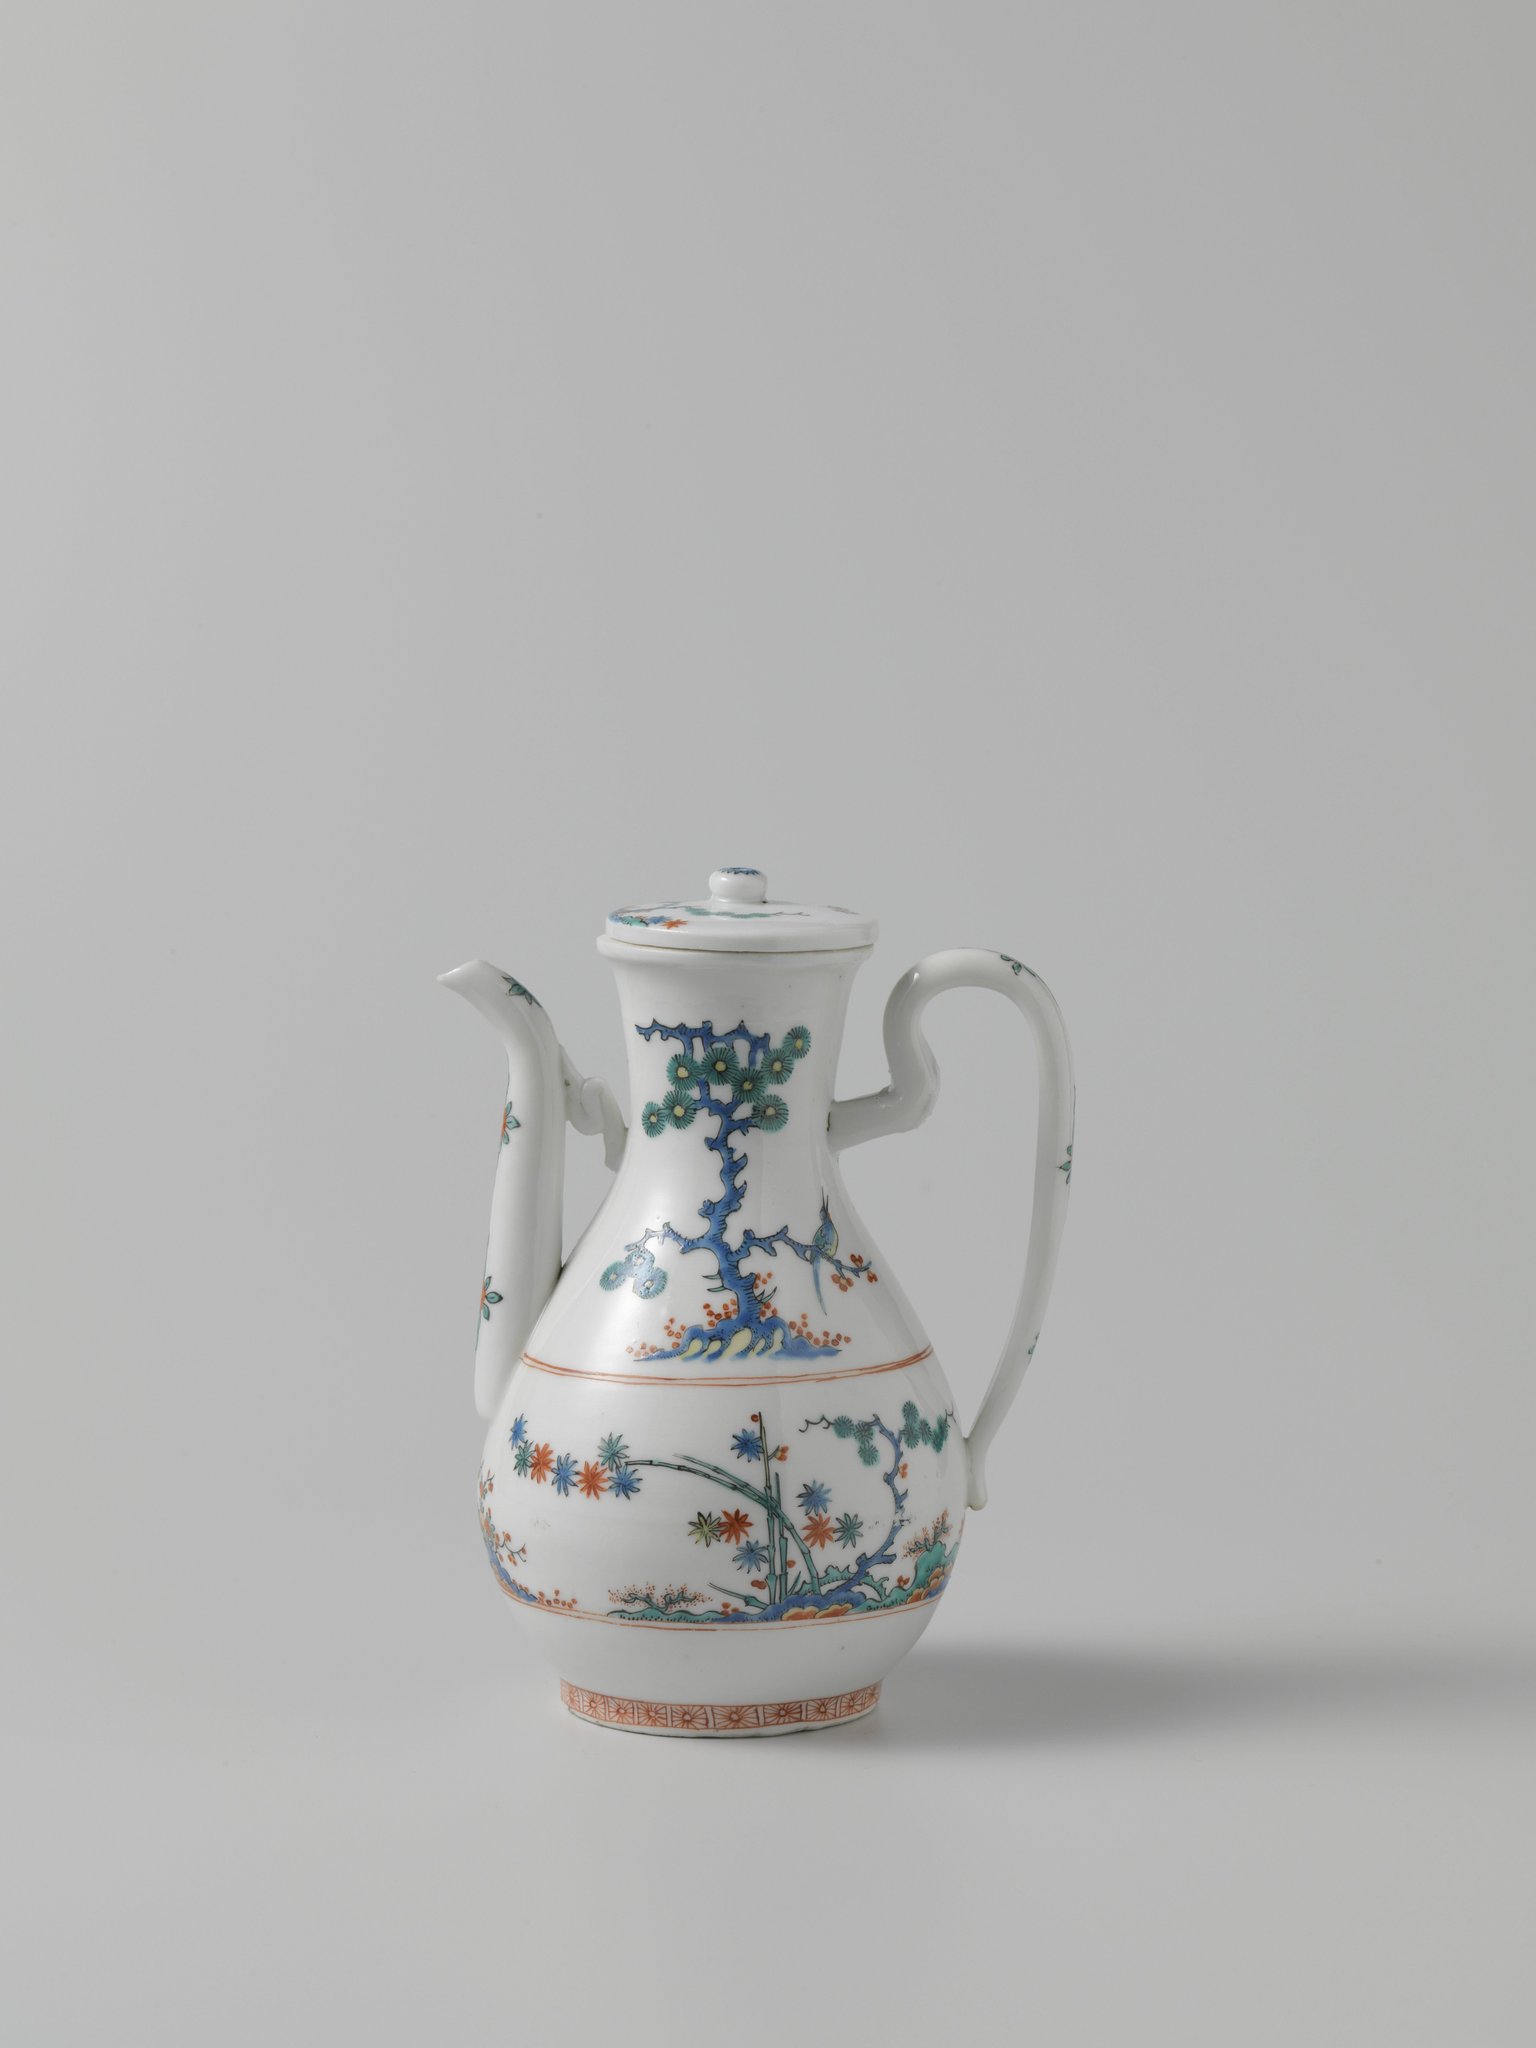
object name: ewer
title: Pear-shaped ewer with the 'three friends of winter'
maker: Anonymous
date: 1700-1724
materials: glaze, paint, porcelain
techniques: firing, turning, vitrification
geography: netherlands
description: Jug with lid. Blanc de Chine, c. 1700 - 1750.